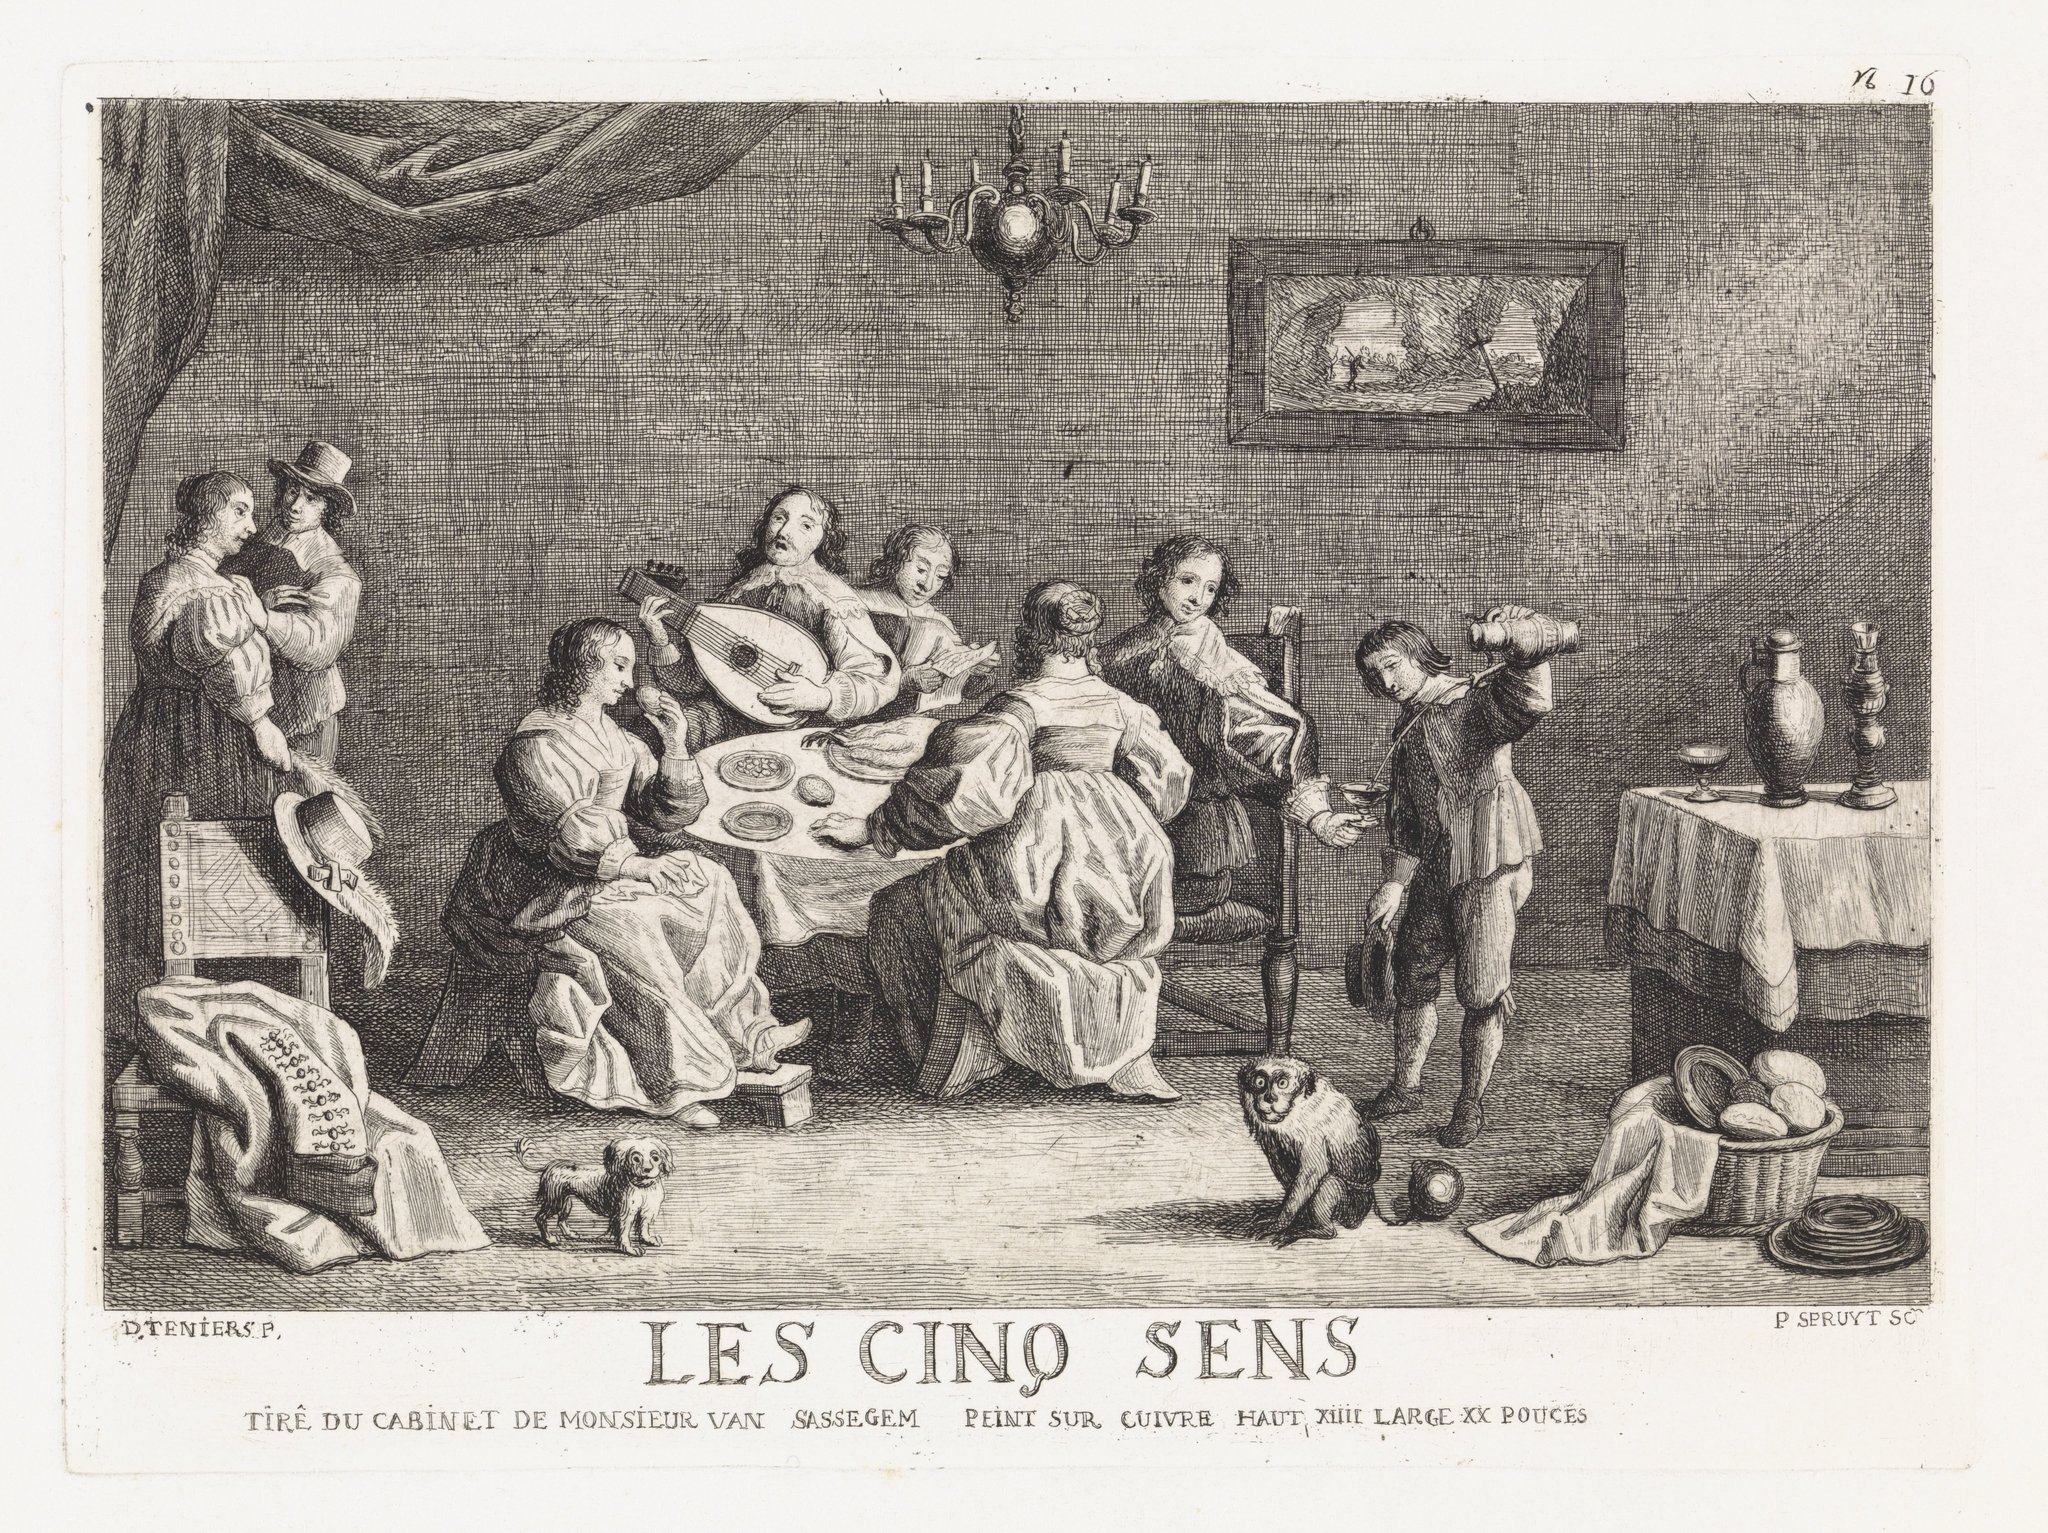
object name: print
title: Les cinq sens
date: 1747-1801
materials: paper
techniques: etching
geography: ghent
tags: the (five) senses, banquet of elegant company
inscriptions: collector's mark: Lugt 2228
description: Allegorische voorstelling van de vijf zintuigen. In een interieur zit een feestvierend gezelschap. De page, die de wijn inschenkt, verbeeldt de smaak. De luitspeler en de zingende jongen verwijzen naar het gehoor, terwijl de dame die aan een citroen ruikt de reuk symboliseert. Het elkaar aanrakende paar links verbeeldt het zintuig van gevoel. Het gezicht wordt verbeeld door de starende aap en het schilderij aan de muur. Rechtsboven genummerd: N. 16.